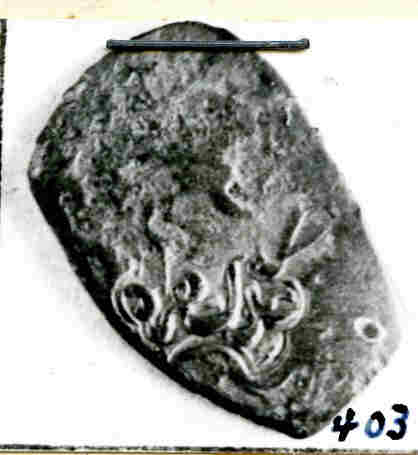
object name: coin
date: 401-1400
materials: copper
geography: herat